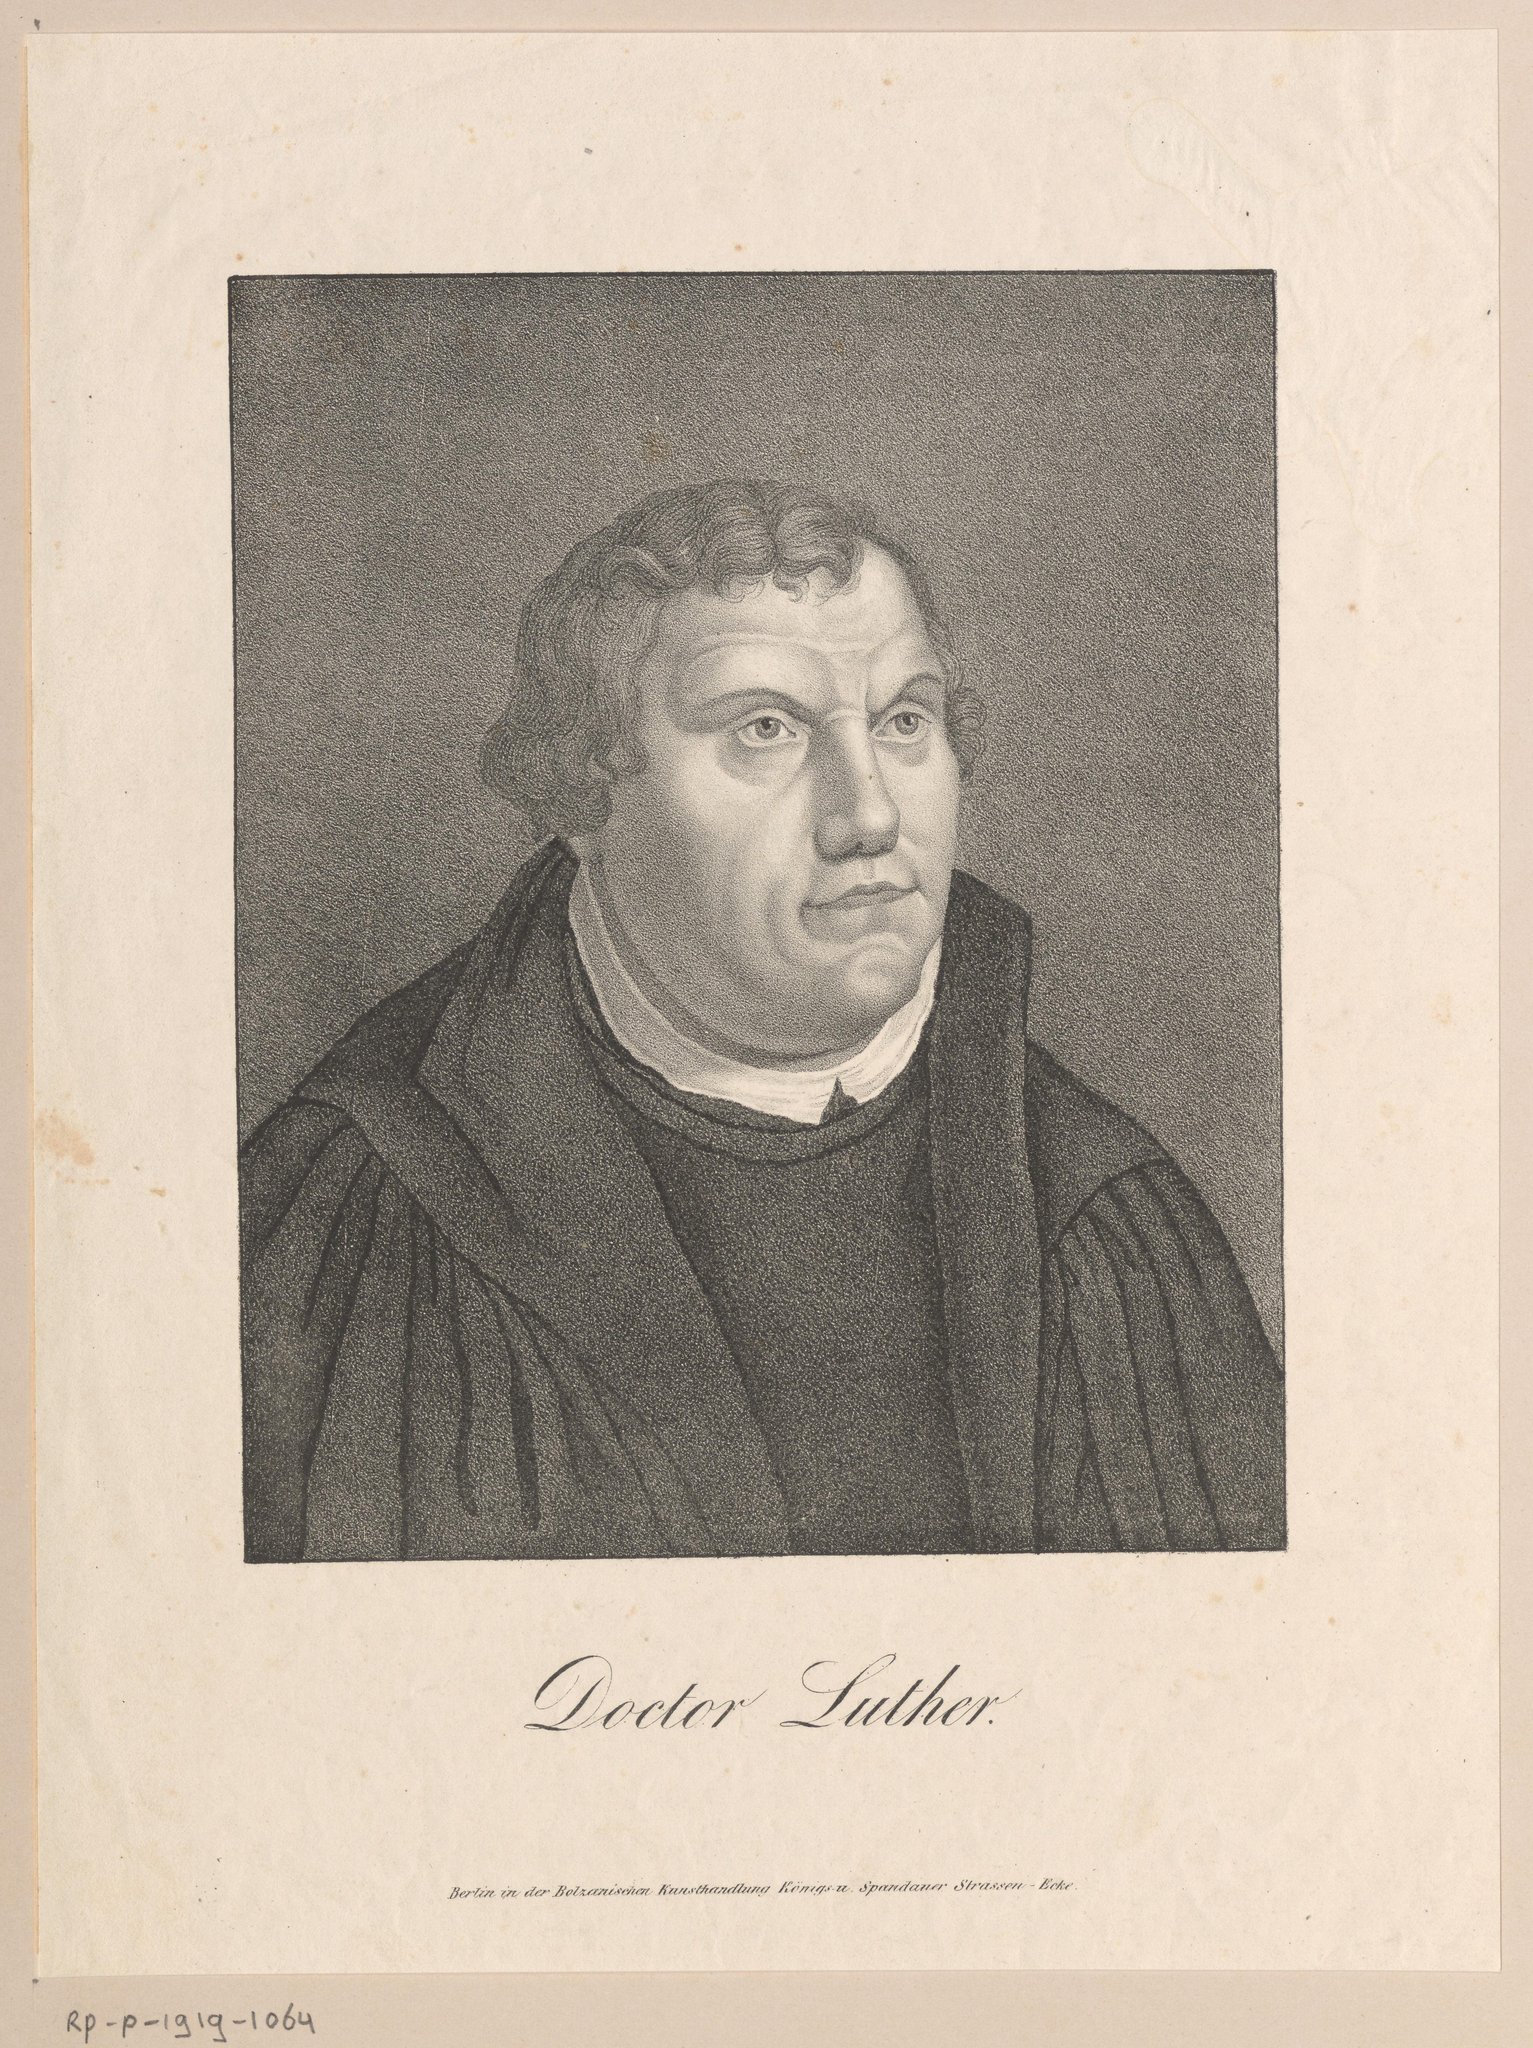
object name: print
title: Portret van Martin Luther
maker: Anonymous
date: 1800-1899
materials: paper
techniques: lithograph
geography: berlin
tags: priest, martin luther, theologian, historical persons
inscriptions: collector's mark: Lugt 2228